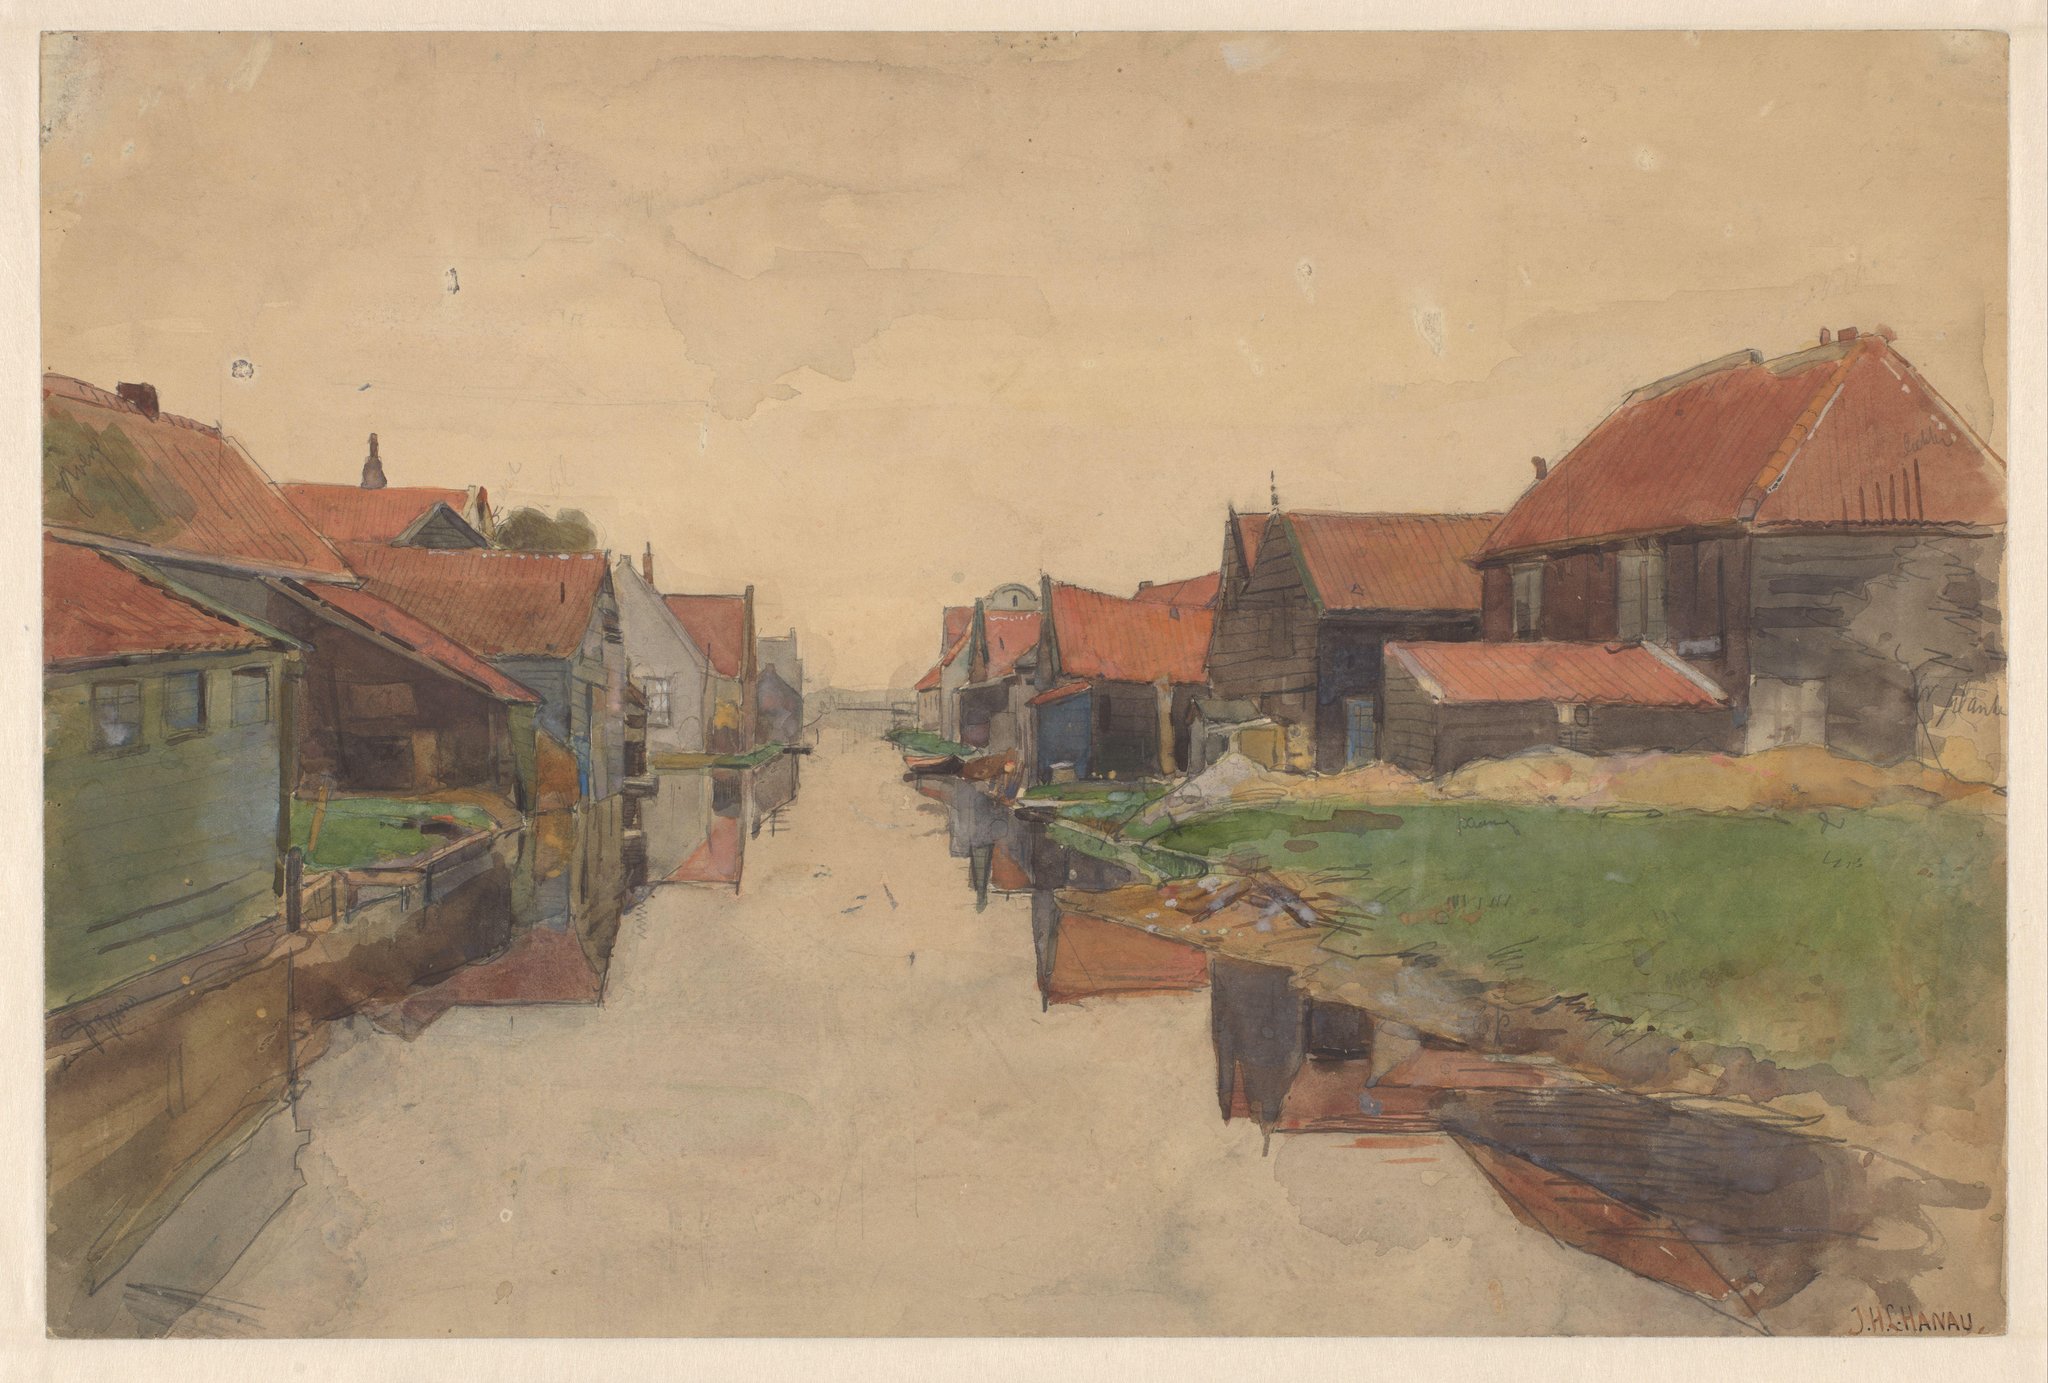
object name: drawing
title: Vinkenbuurt te Amsterdam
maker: jan h.l. hanau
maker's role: draughtsman, print maker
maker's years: 1864-1925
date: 1886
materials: paper, pencil, watercolor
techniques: brush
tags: civic architecture; edifices; dwellings, small canal, ditch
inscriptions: collector's mark: Lugt 2233, inscription: ‘J.H.L. Hanau/ "Vinkenbuurt" (A'dam)/ 1886-’